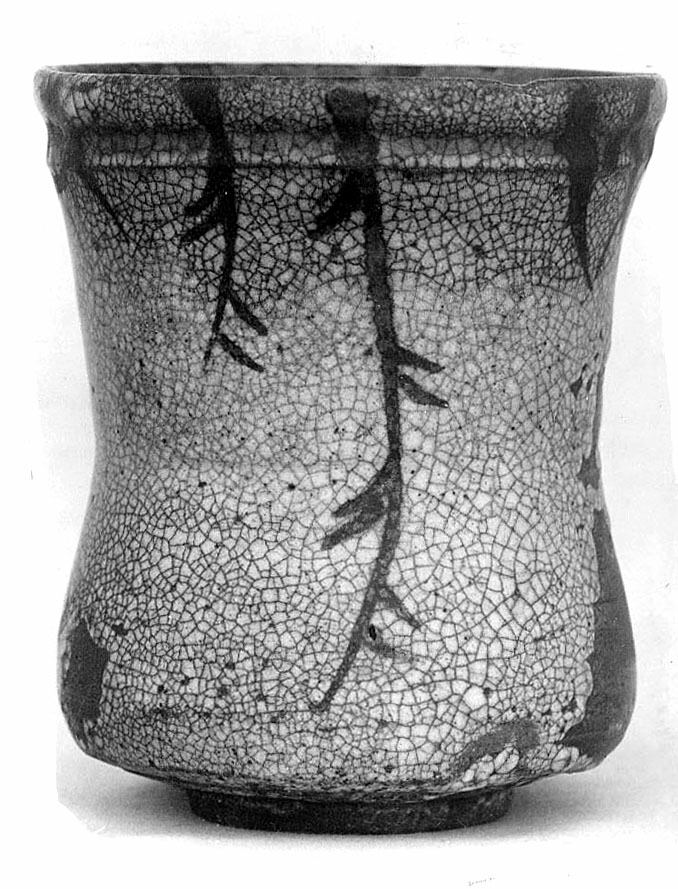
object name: bowl, deep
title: Deep Bowl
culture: japanese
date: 1780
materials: glaze, pottery